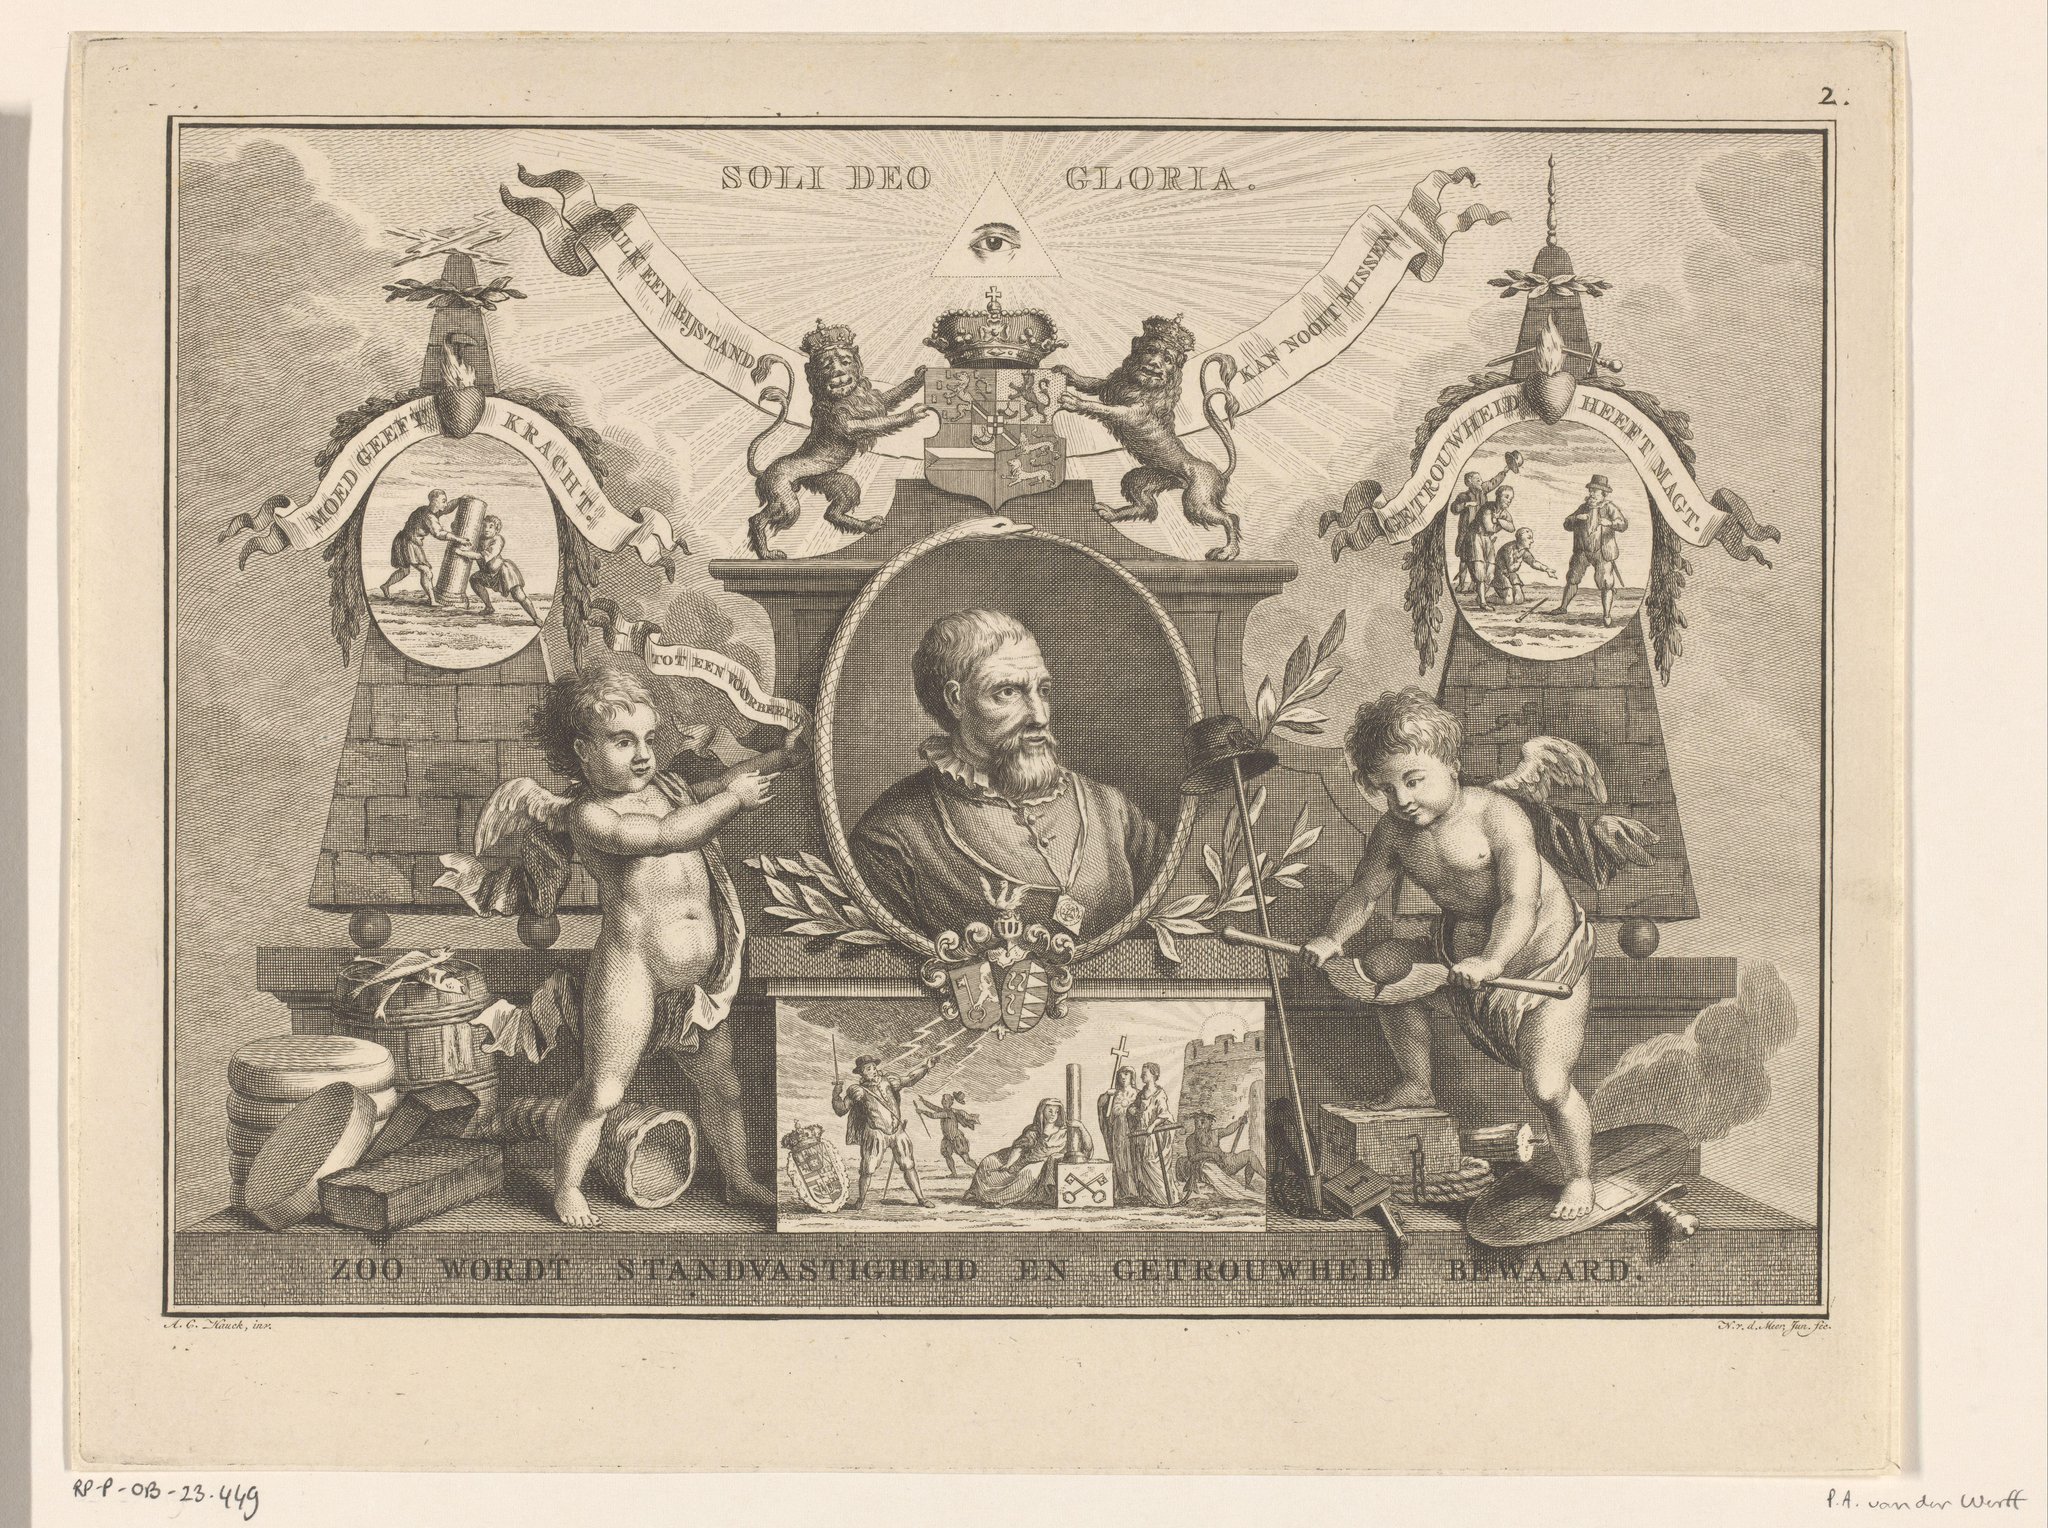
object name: print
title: Allegorisch portret van Pieter Adriaansz. van der Werff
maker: august christian hauck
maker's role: draughtsman, painter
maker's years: 1742-1801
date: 1751-1822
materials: paper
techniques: engraving, etching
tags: freedom, liberty; 'libertà' (ripa) (+ allegorical scene, i.e. two or more personifications involved in an action), fortitude, 'fortitudo' ~ one of the four cardinal virtues, yoke, cupids: 'amores', 'amoretti', 'putti'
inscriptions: collector's mark: Lugt 2228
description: Portret van Pieter Adriaansz. van der Werff, burgemeester van Leiden ten tijde van het ontzet van Leiden. Het portret bevindt zich op een monument en wordt geflankeerd door putti. De een toont een banderol, de ander breekt een juk en staat naast een vrijheidslans. Midden boven het alziend oog van God. Midden onder het portret een allegorische voorstelling met de stedenmaagd van Leiden.